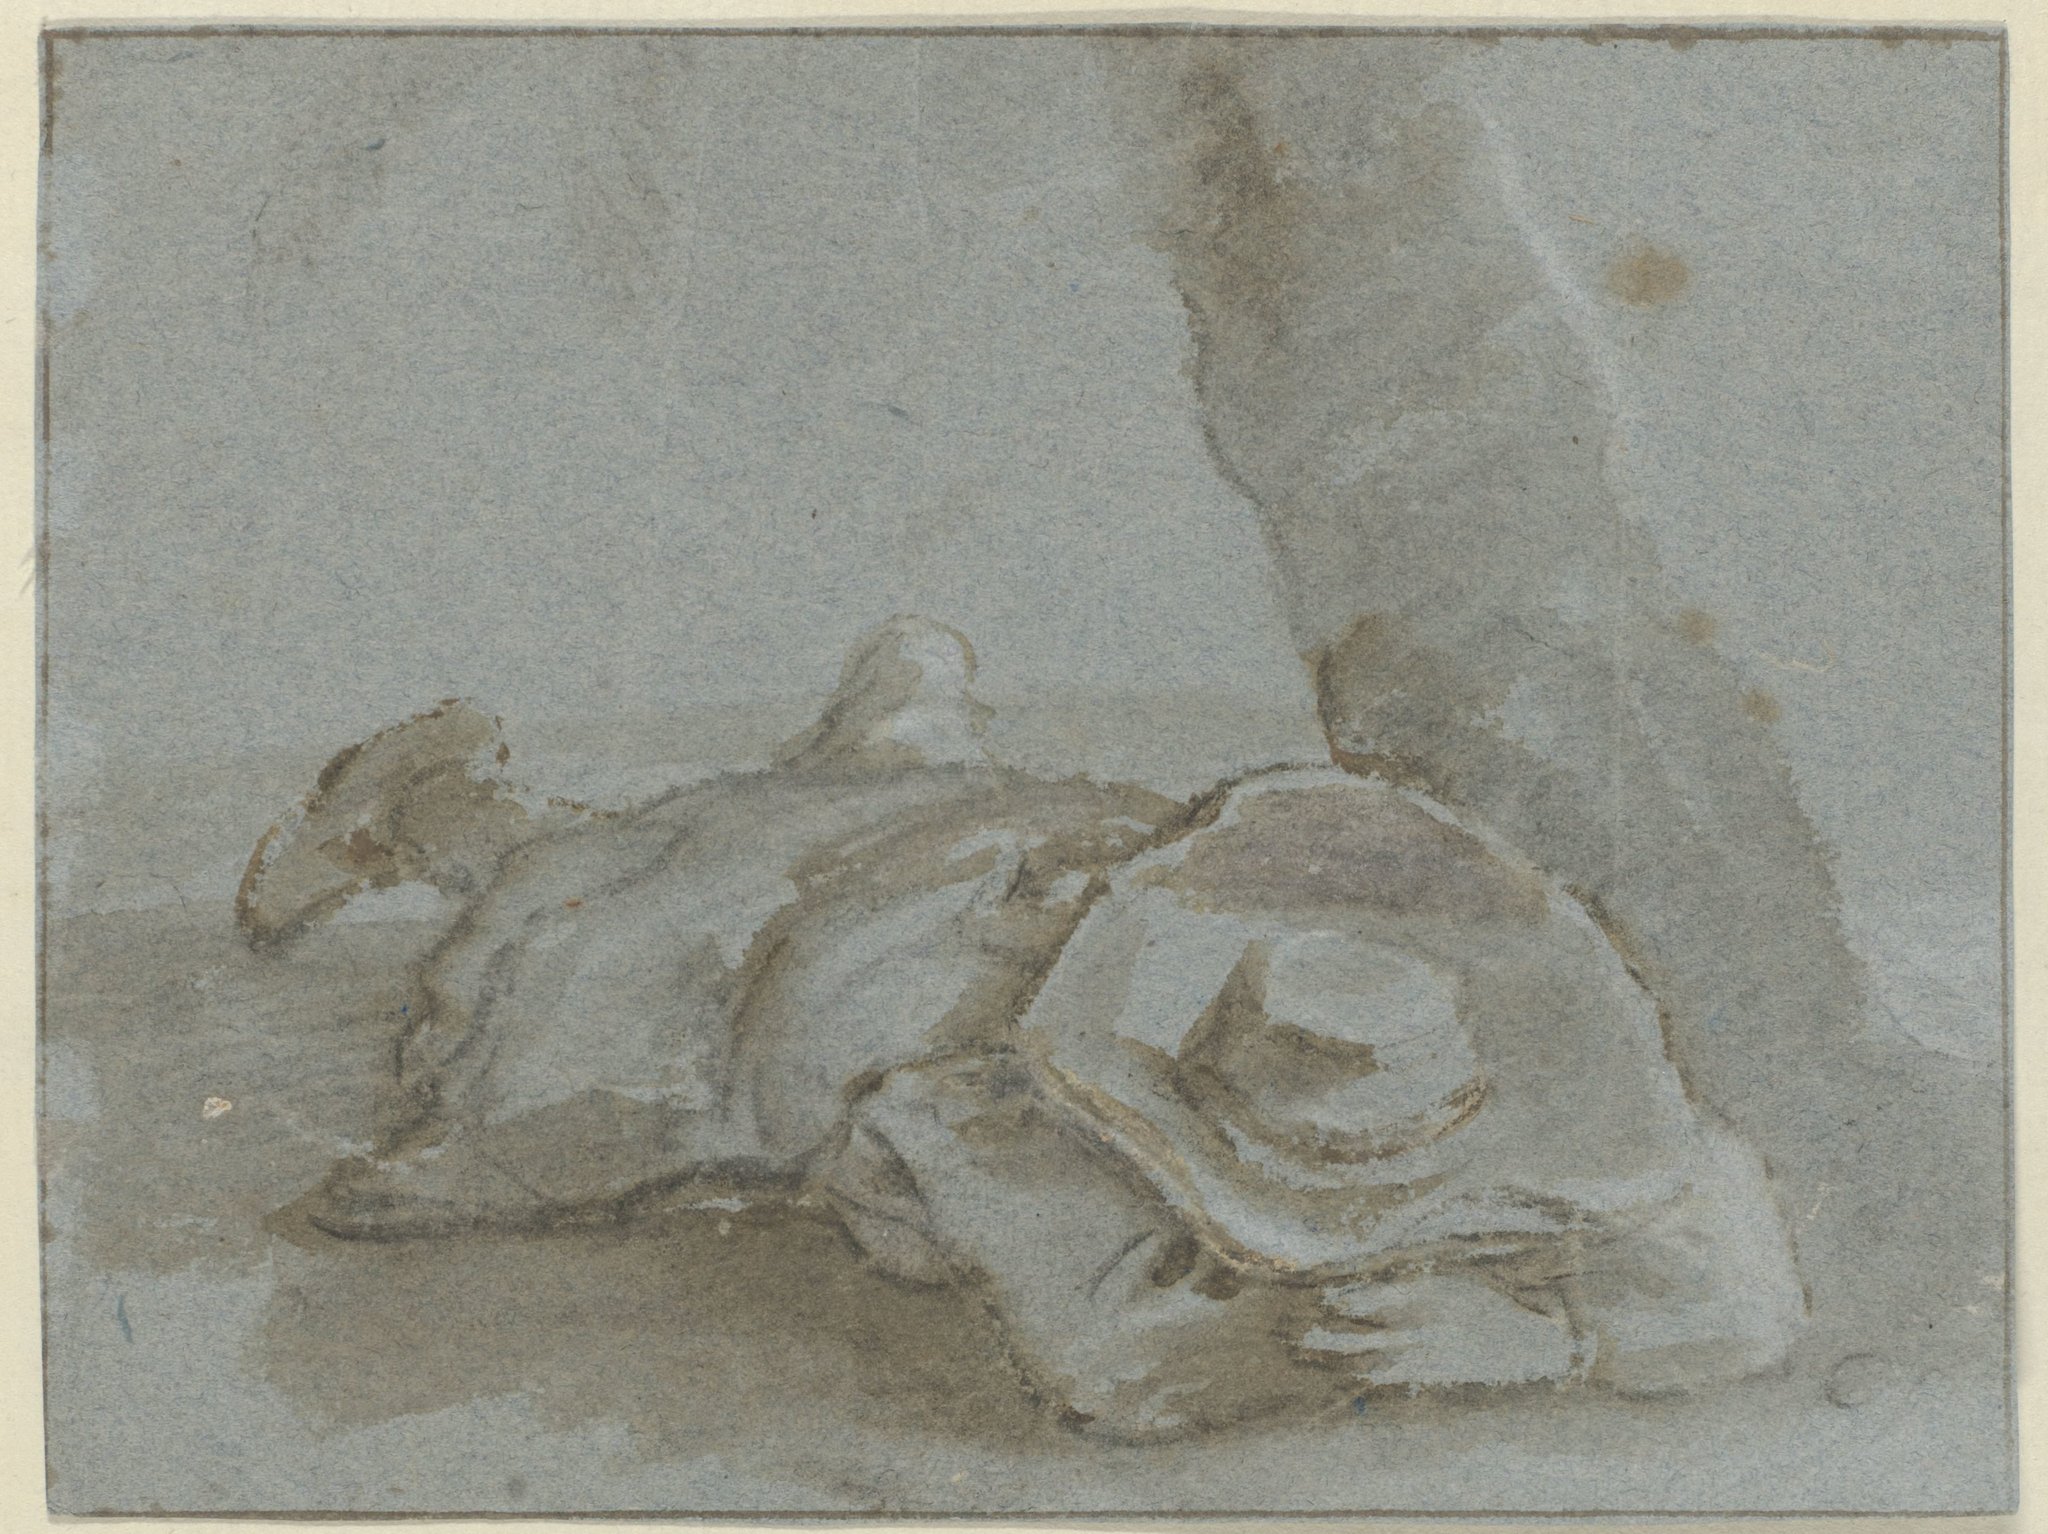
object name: drawing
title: Op zijn buik liggende man met hoed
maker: Anonymous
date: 1600-1799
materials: chalk, paper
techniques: brush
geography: netherlands